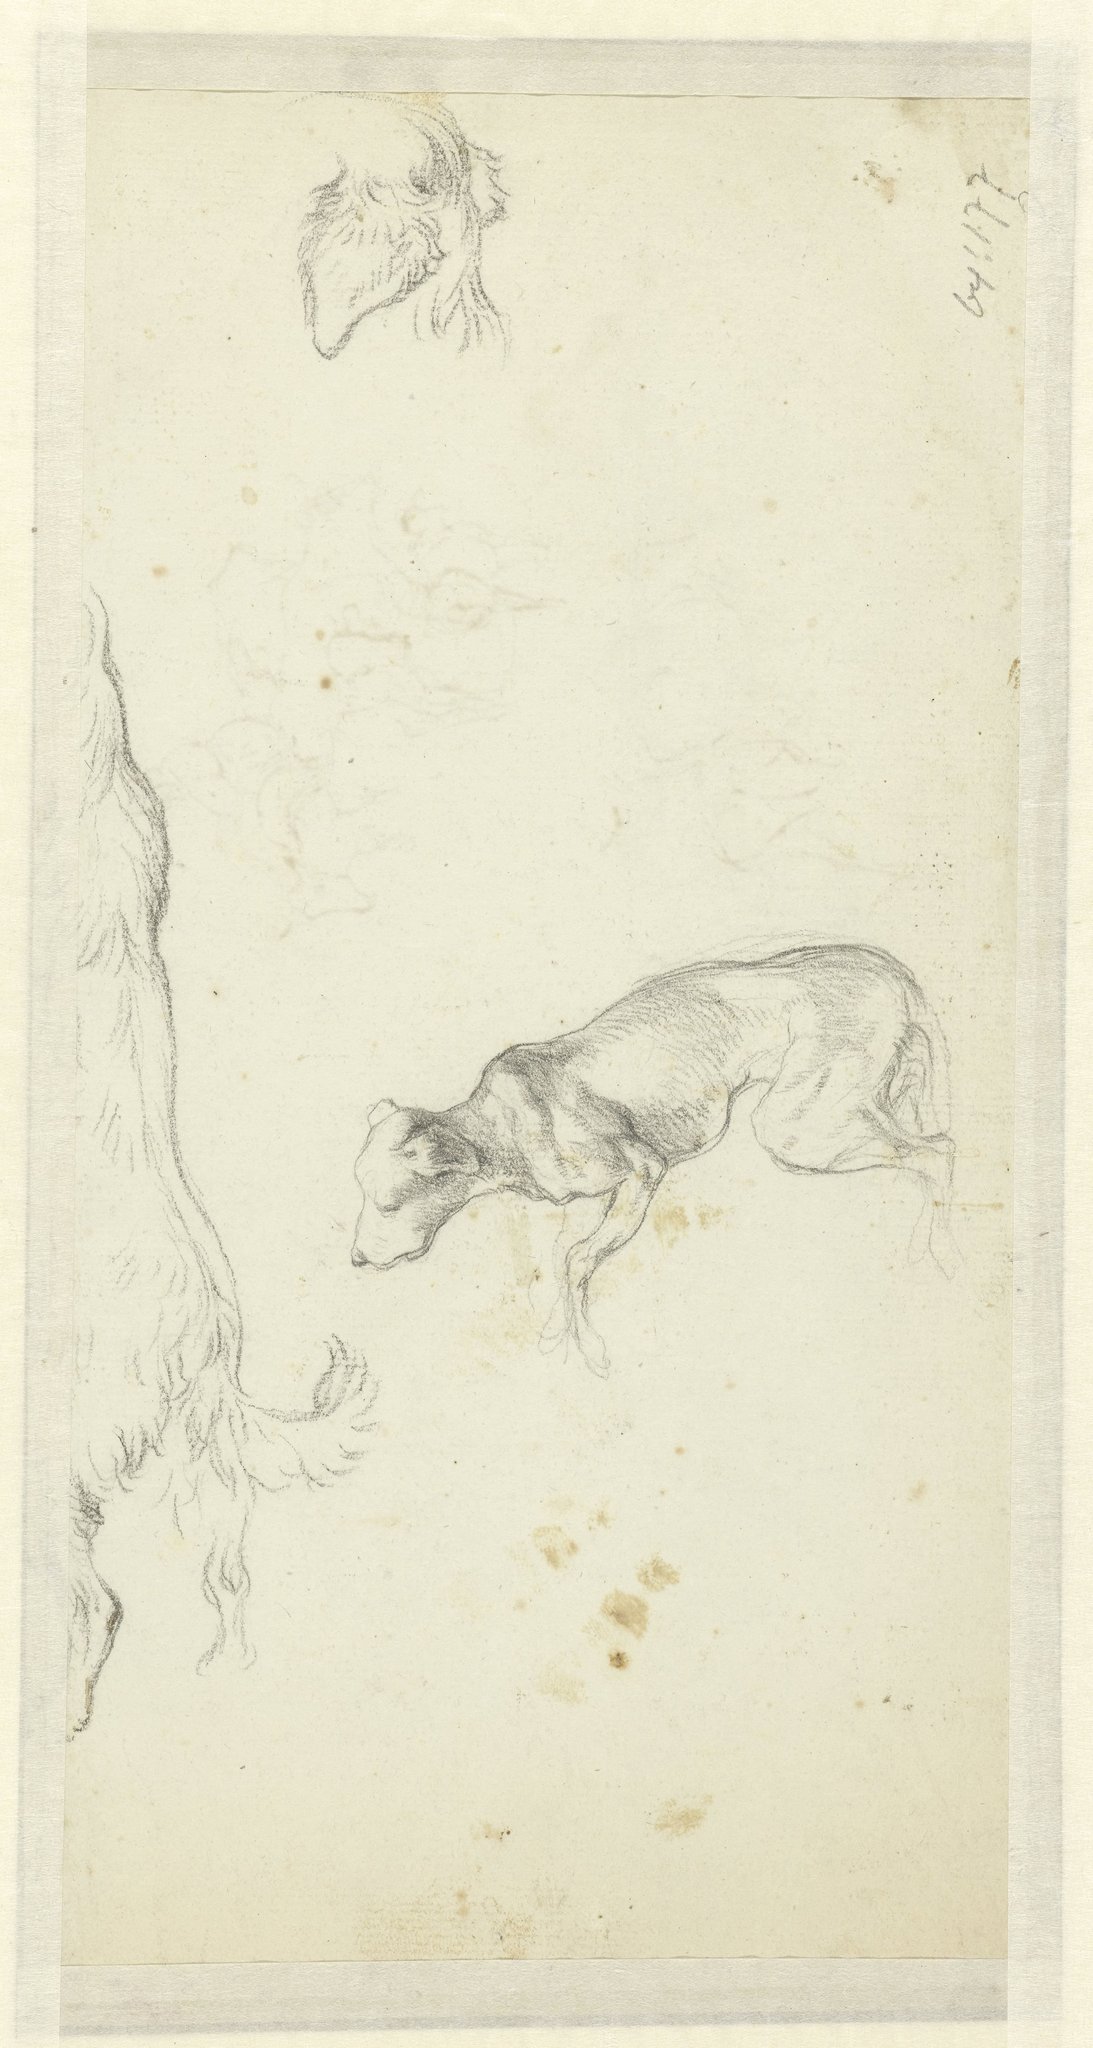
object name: drawing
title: Drie hondenstudies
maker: jean louis demarne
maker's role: draughtsman, painter, print maker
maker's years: 1752-1829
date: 1754-1829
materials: chalk, ink, paper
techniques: pen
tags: dog